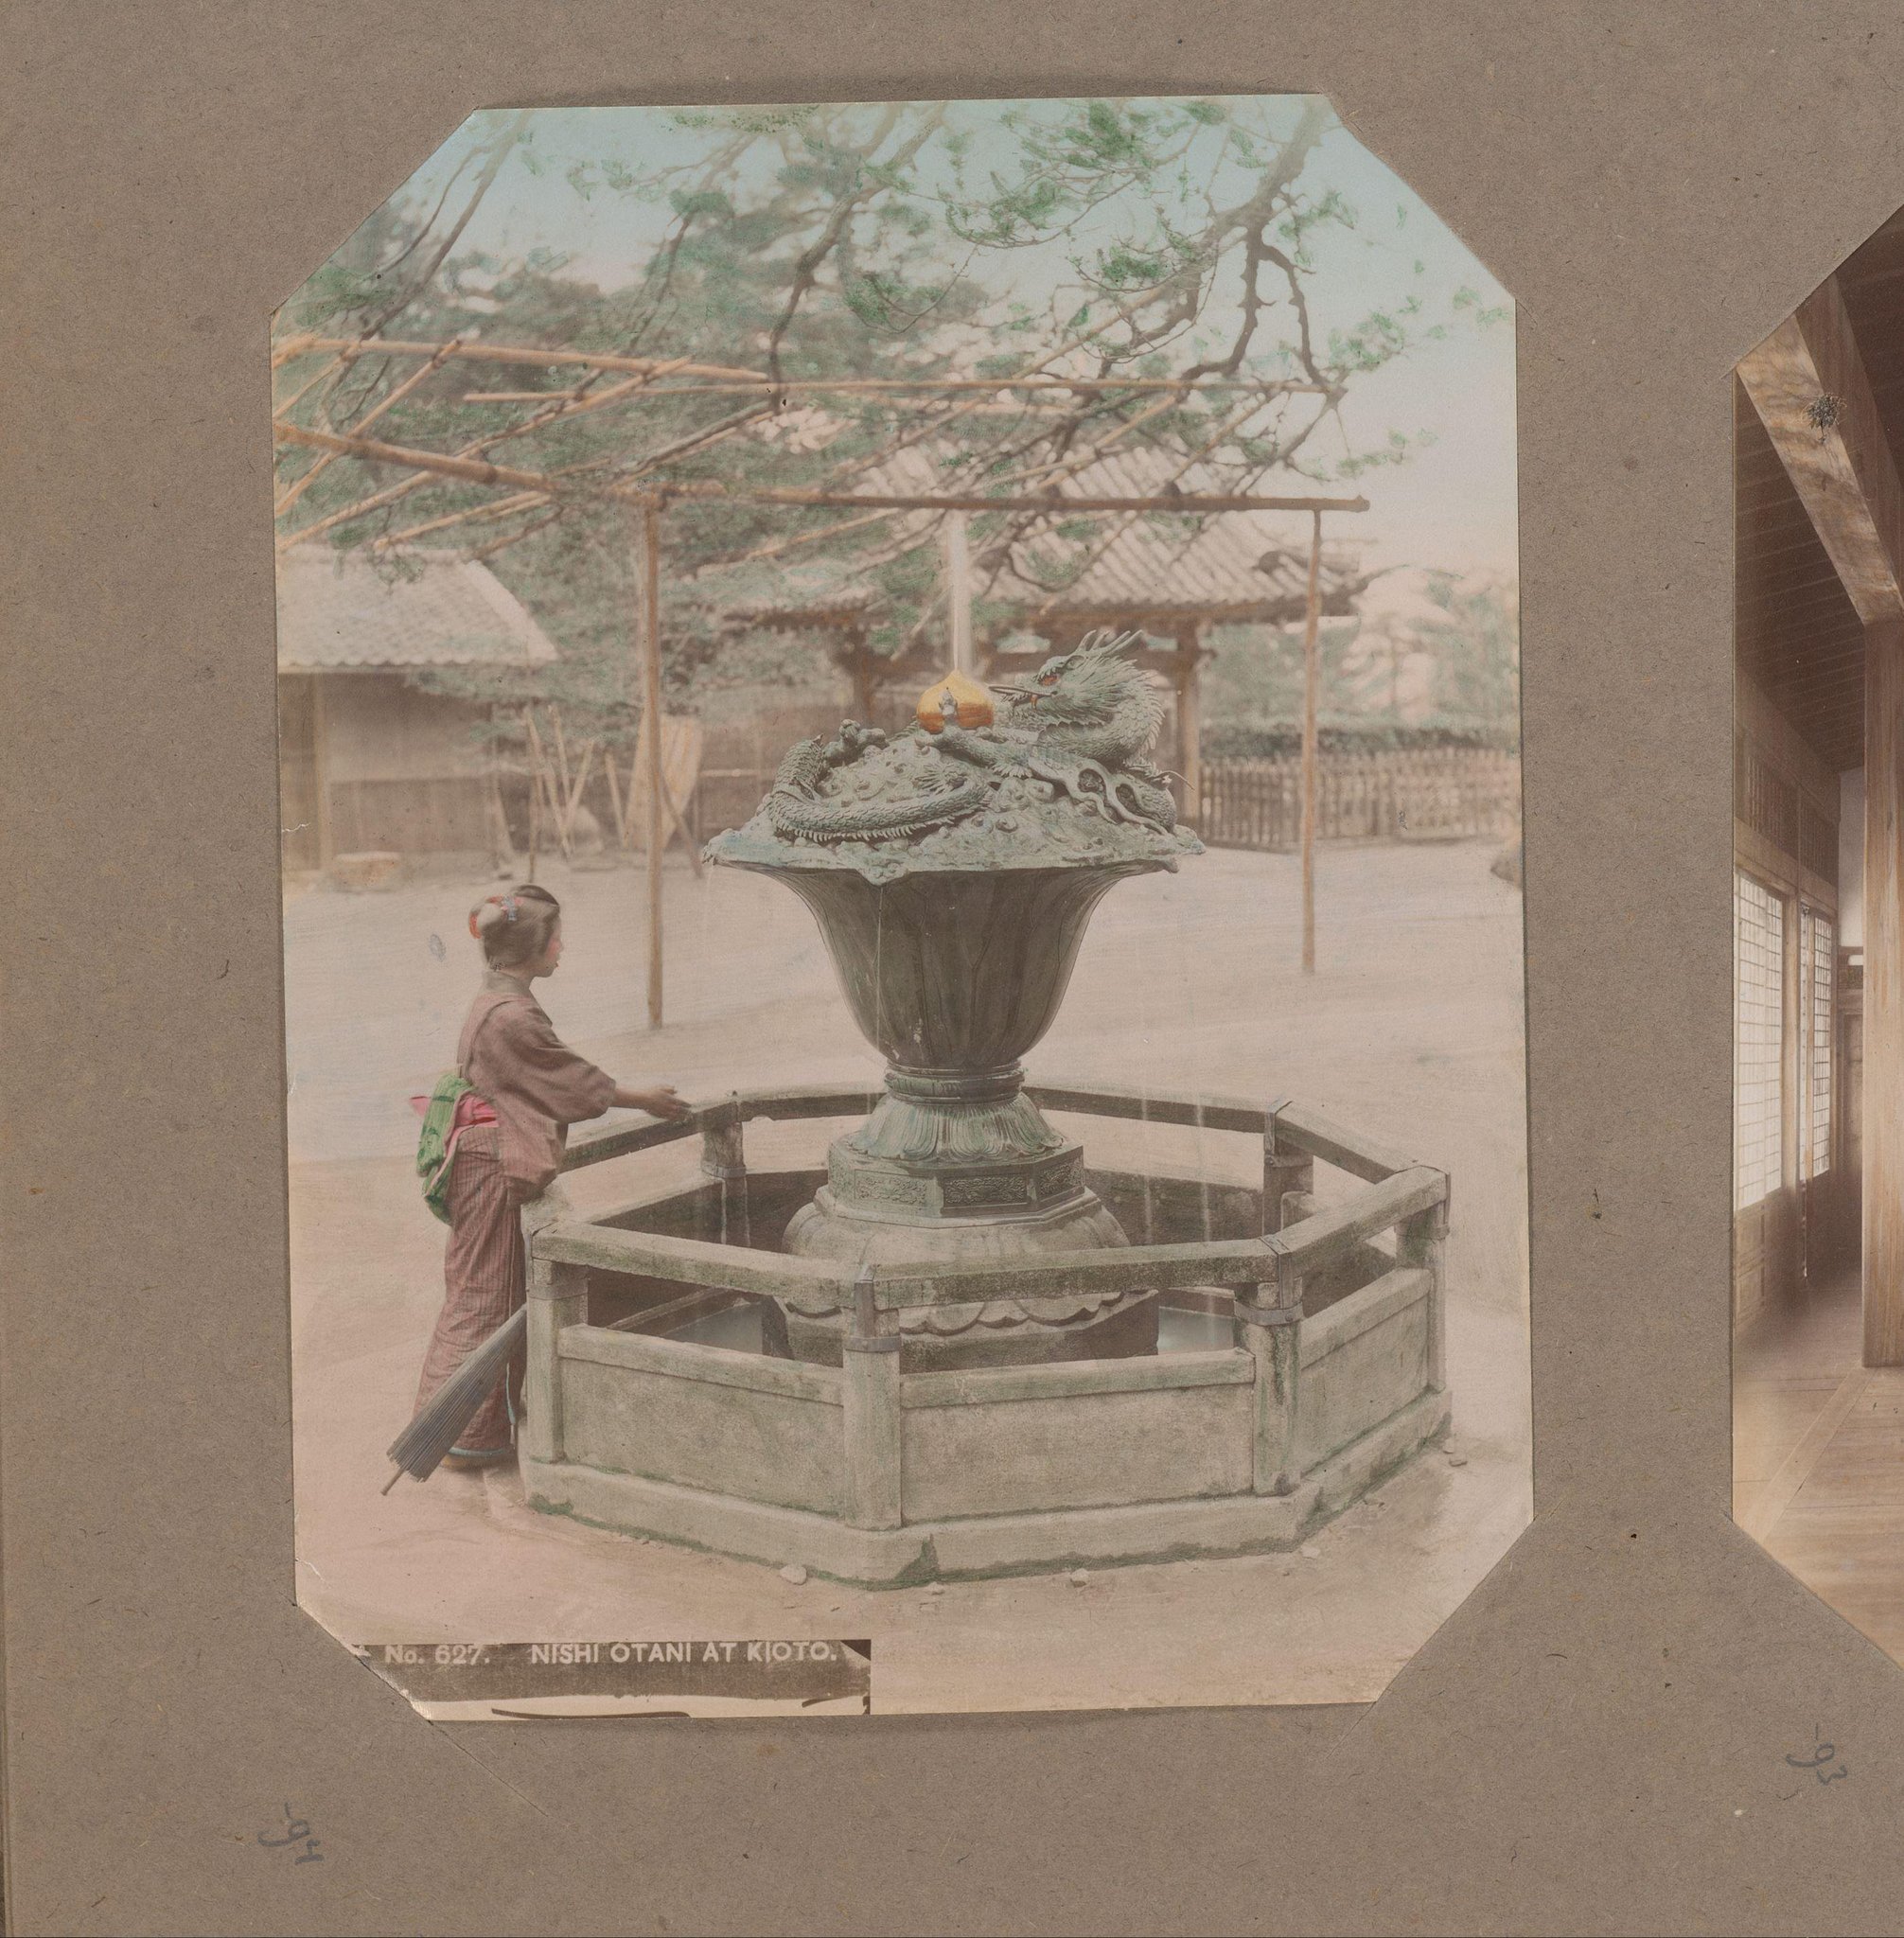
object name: album leaf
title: Vrouw bij een fontein in Nishi Otani, Kyoto, Japan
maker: Anonymous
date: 1890-1903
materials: paper, photographic support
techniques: albumen print, hand coloring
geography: kyoto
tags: adult woman, ornamental fountain, kyoto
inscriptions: inscription: ‘No. 627. Nishi Otani at Kioto’